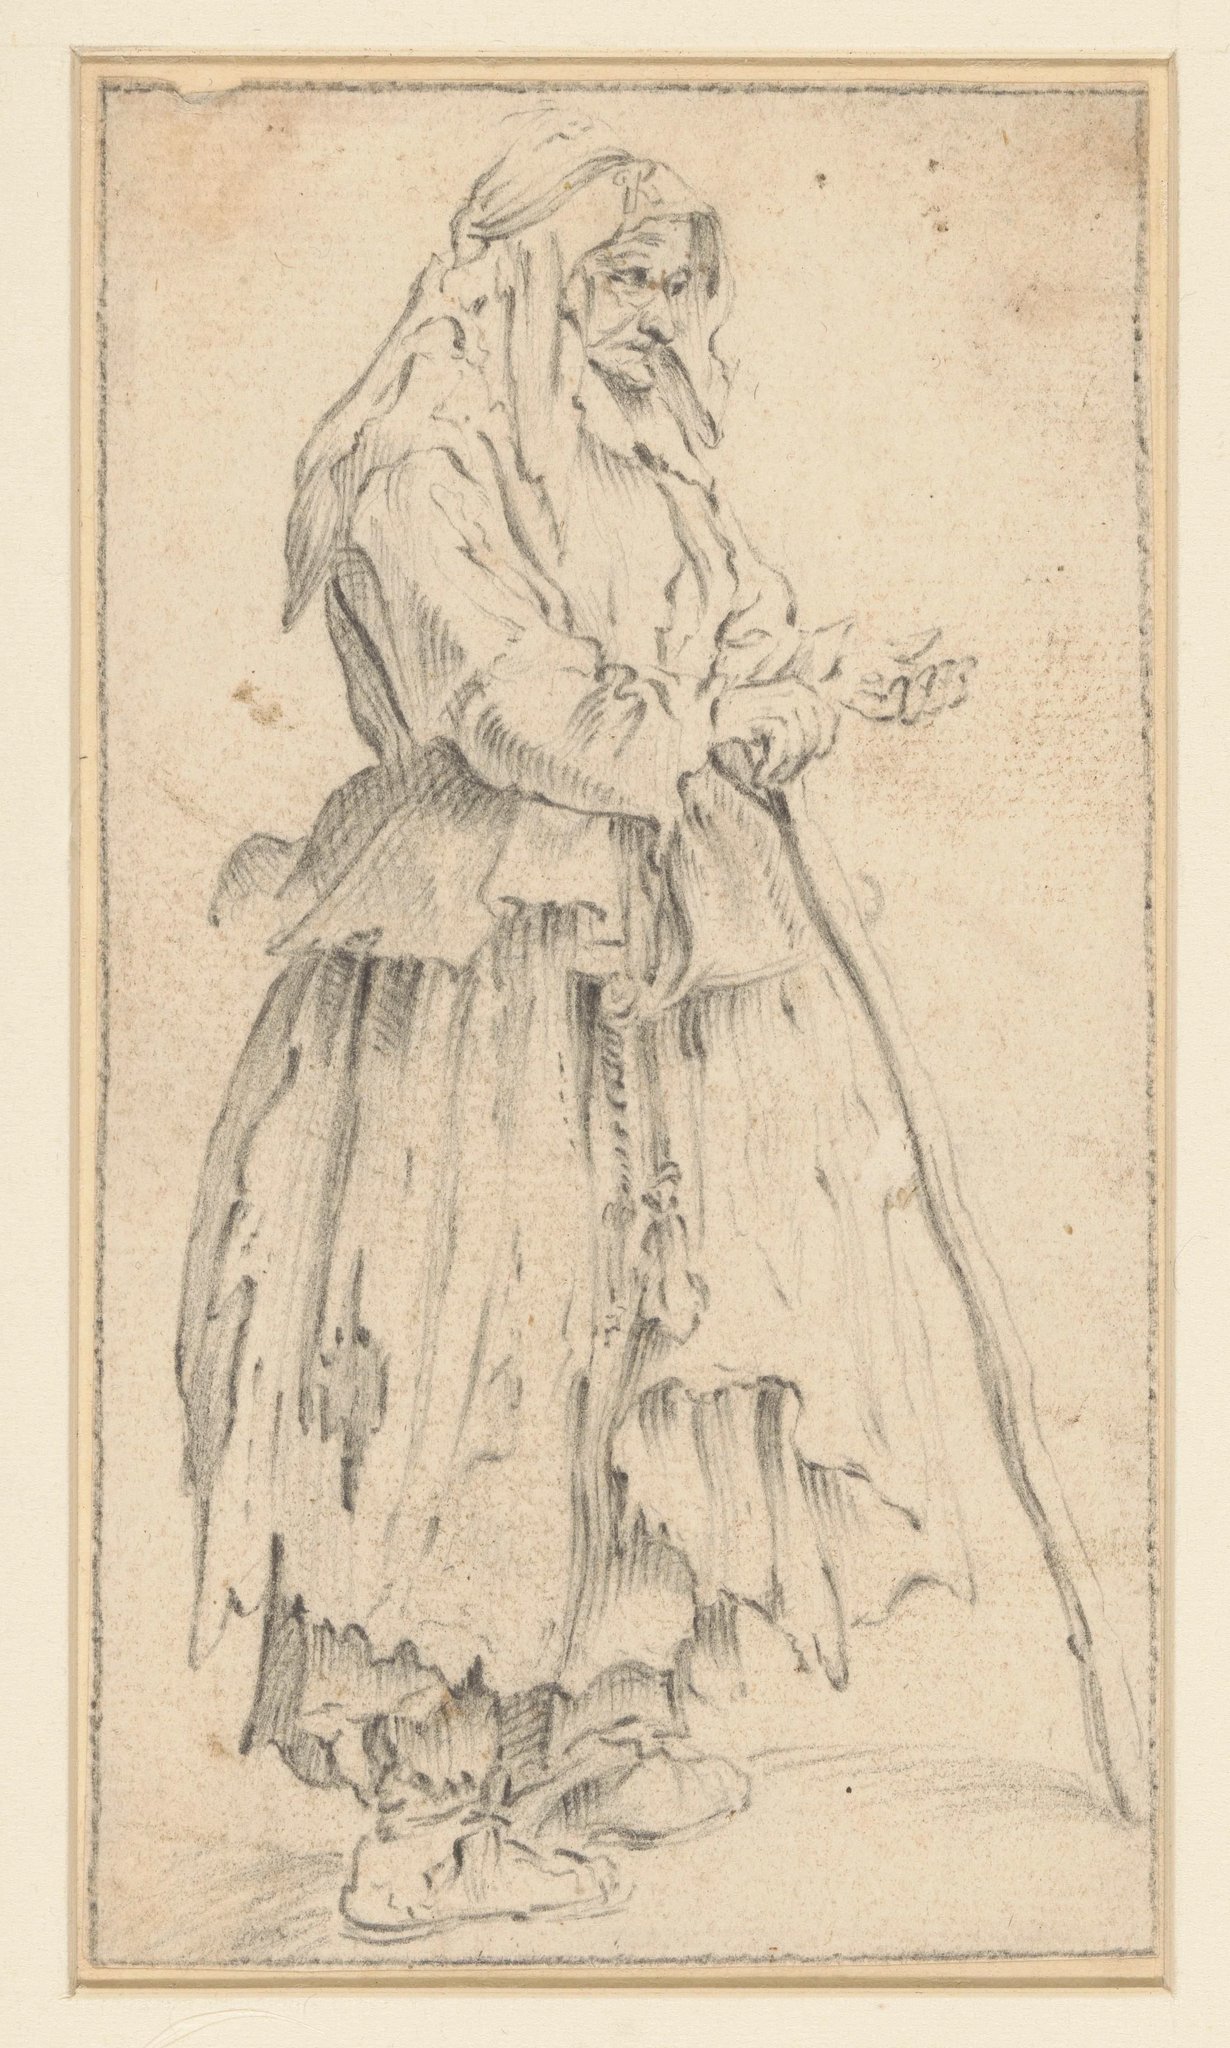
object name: drawing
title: Bedelares met stok, naar rechts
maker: Anonymous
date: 1620-1700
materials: chalk, paper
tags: beggar